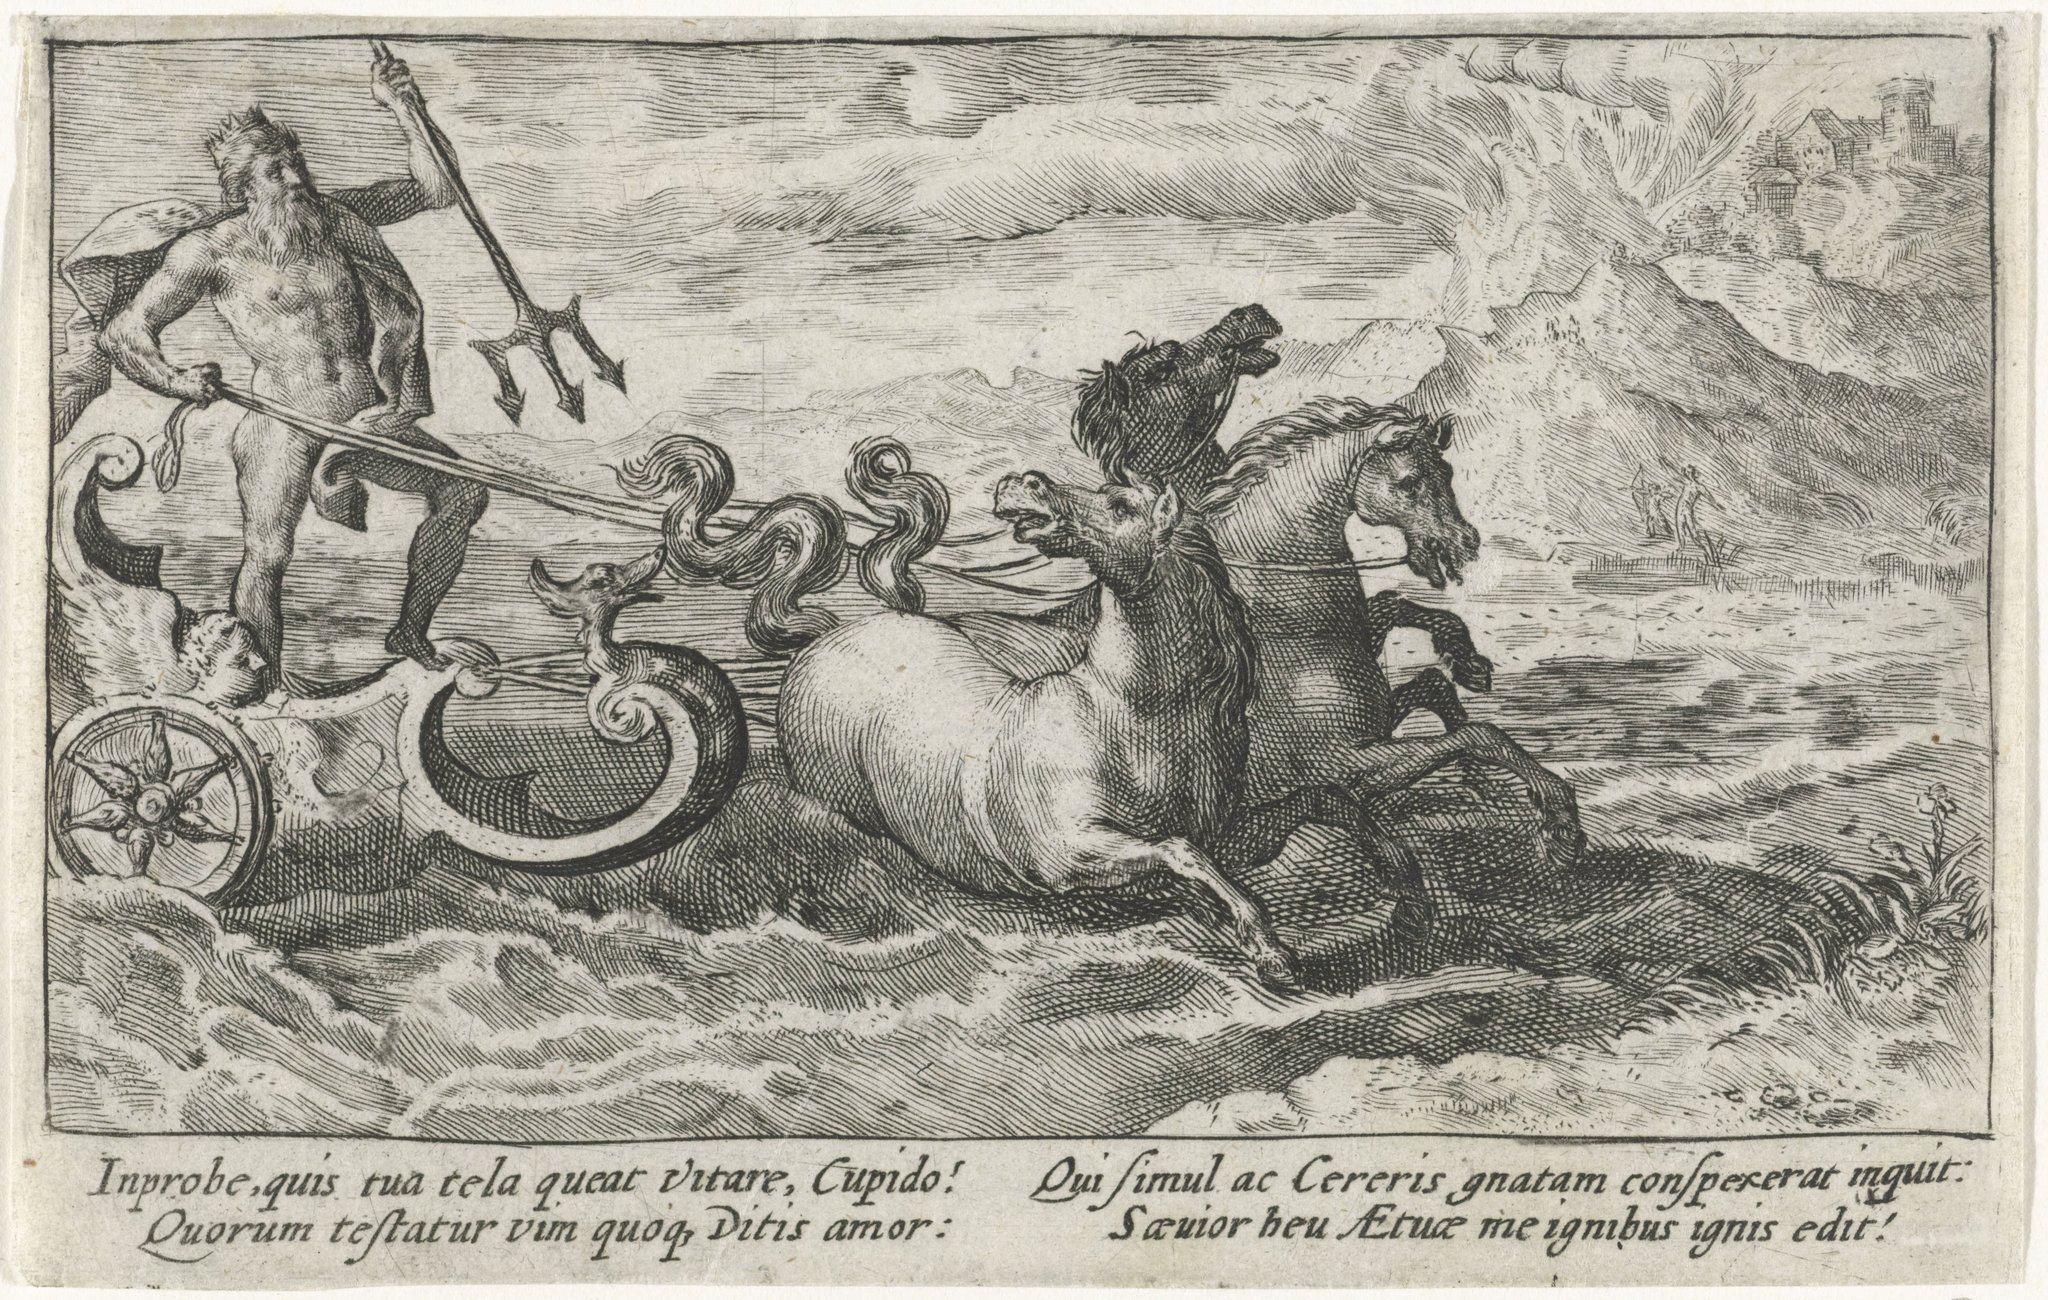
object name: print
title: Metamorfosen van Ovidius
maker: crispijn van de passe (i)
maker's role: draughtsman, print maker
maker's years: 1564-1637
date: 1602-1607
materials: paper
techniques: engraving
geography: cologne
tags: pluto in love with proserpina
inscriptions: collector's mark: Lugt 2228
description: Pluto staat op zijn wagen die wordt voortgetrokken door zeepaarden. In de marge een vierregelig onderschrift, in twee kolommen, in het Latijn.